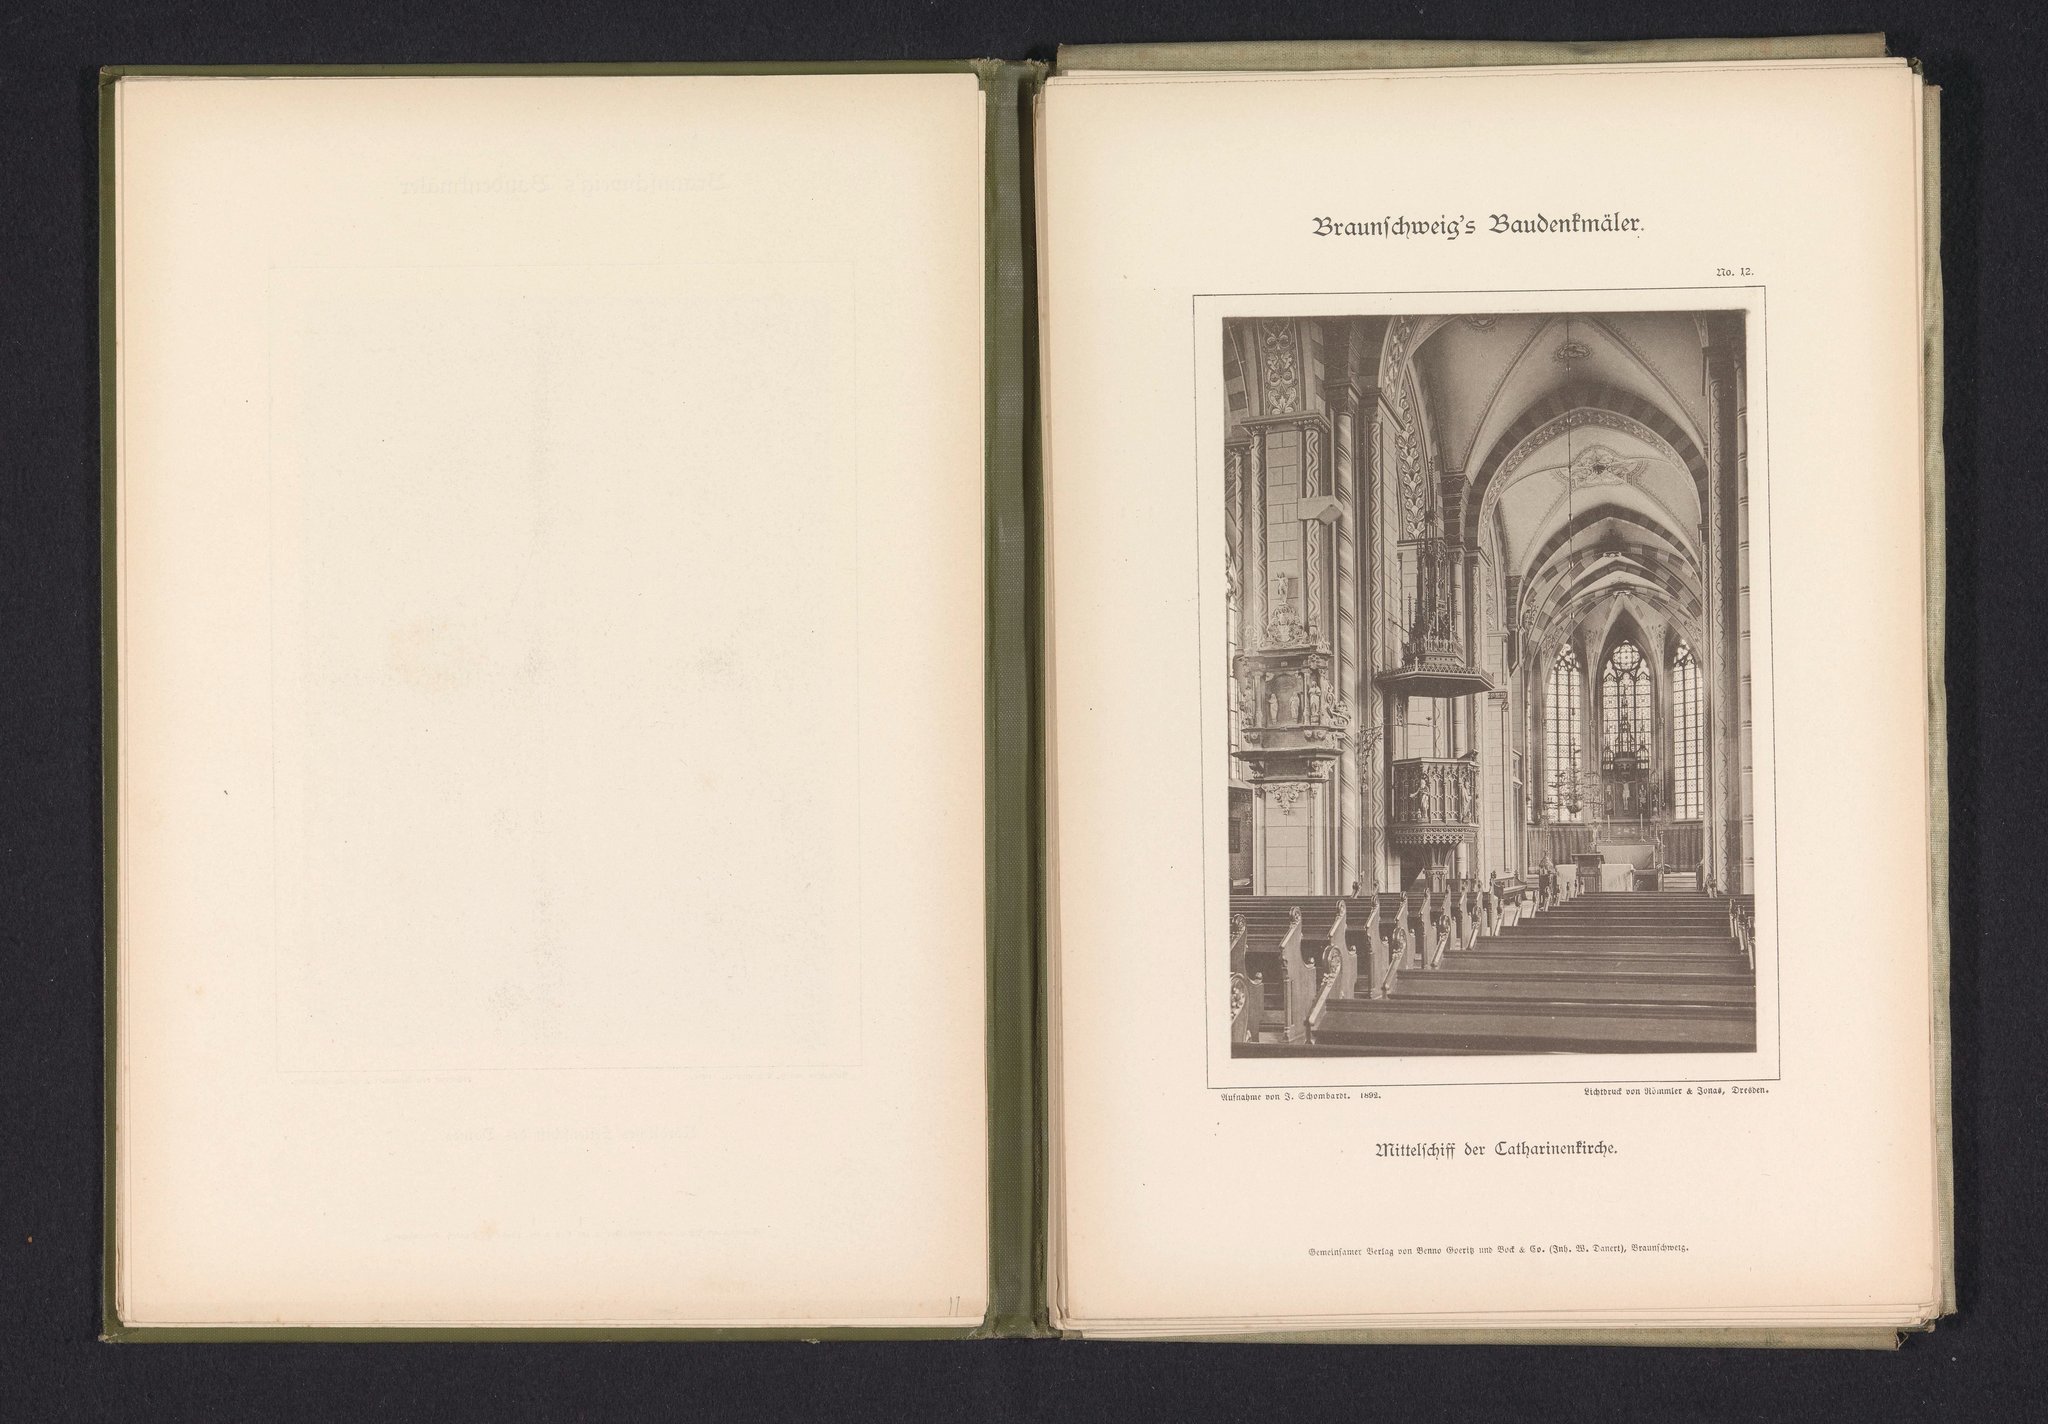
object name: photomechanical print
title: Interieur van het middenschip van de Sint-Catharinakerk te Braunschweig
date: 1892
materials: paper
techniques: photograph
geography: braunschweig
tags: interior of church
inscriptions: number: ‘No. 12.’